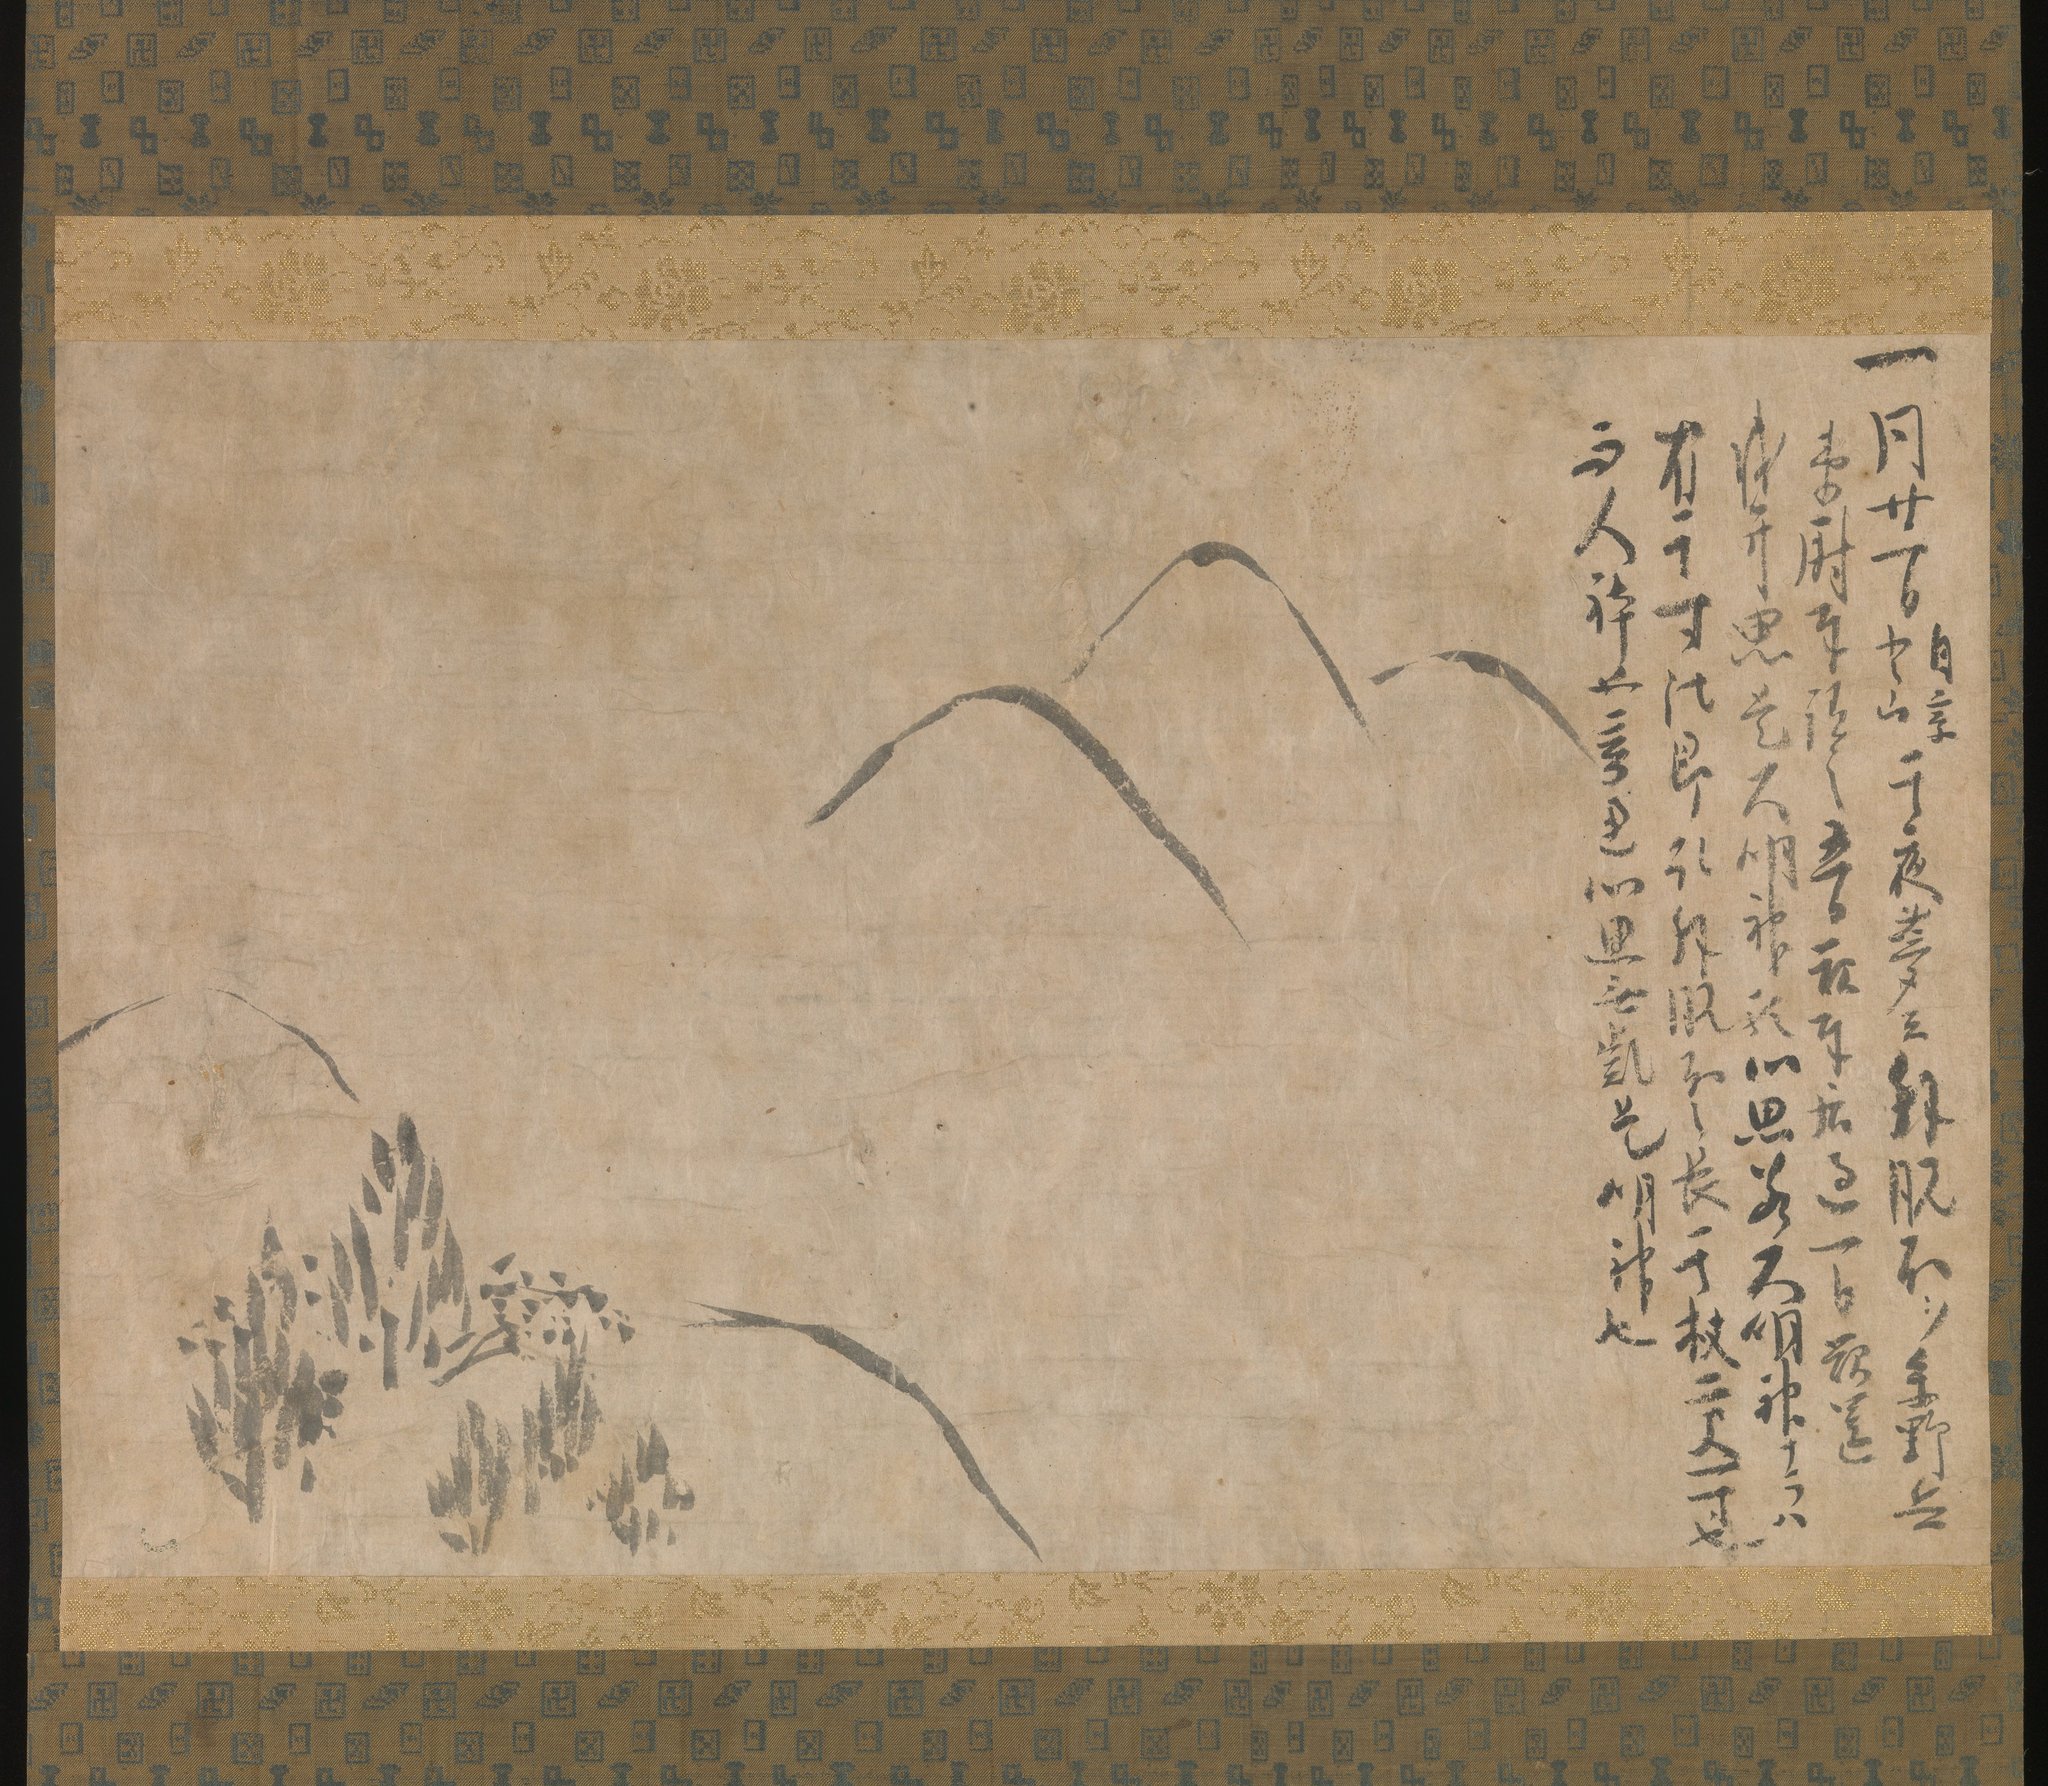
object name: hanging scroll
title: Section of the Dream Diary with a Sketch of Mountains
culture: japanese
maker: myōe kōben 明恵高弁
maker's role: artist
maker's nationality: japanese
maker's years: 1173-1232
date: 1203-1210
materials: ink, paper